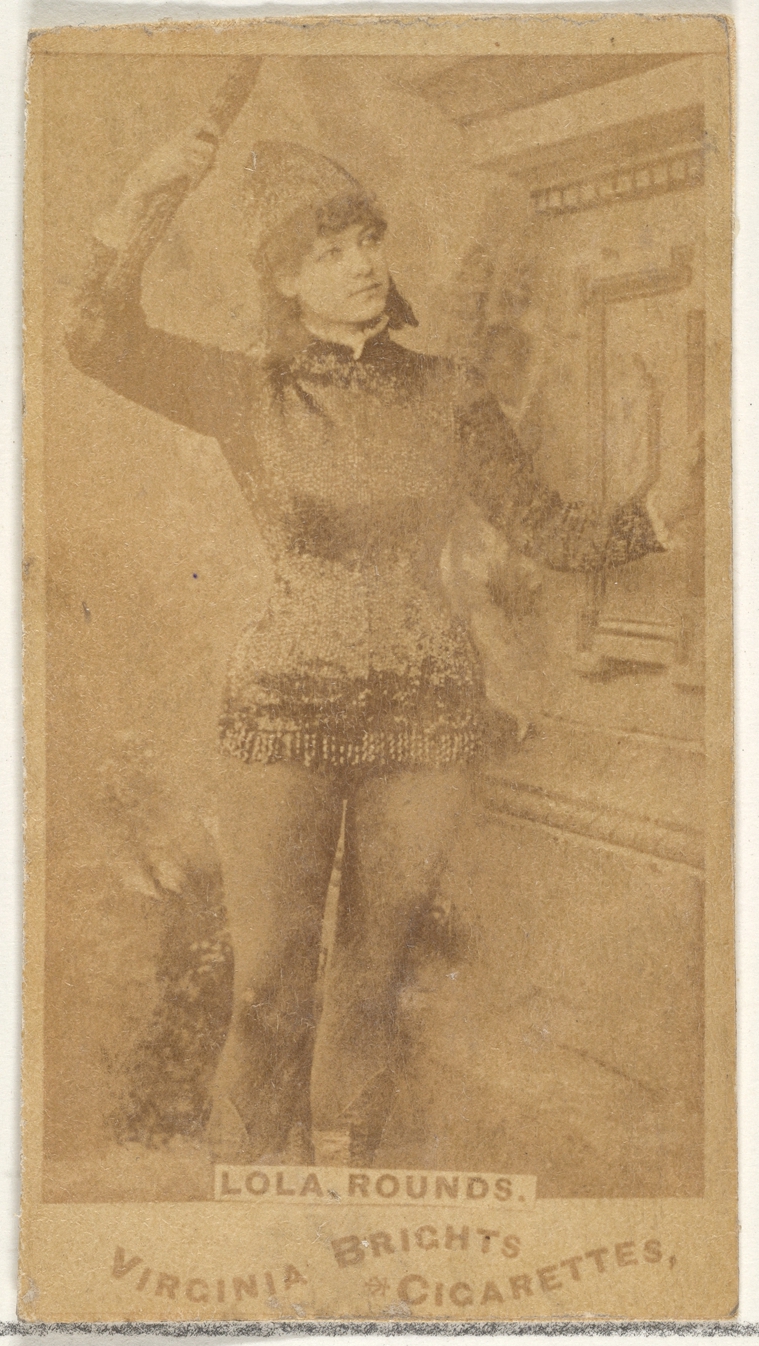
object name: photograph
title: Lola Rounds, from the Actors and Actresses series (N45, Type 1) for Virginia Brights Cigarettes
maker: allen & ginter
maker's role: publisher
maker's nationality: american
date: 1888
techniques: albumen silver print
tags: portraits,women,actresses